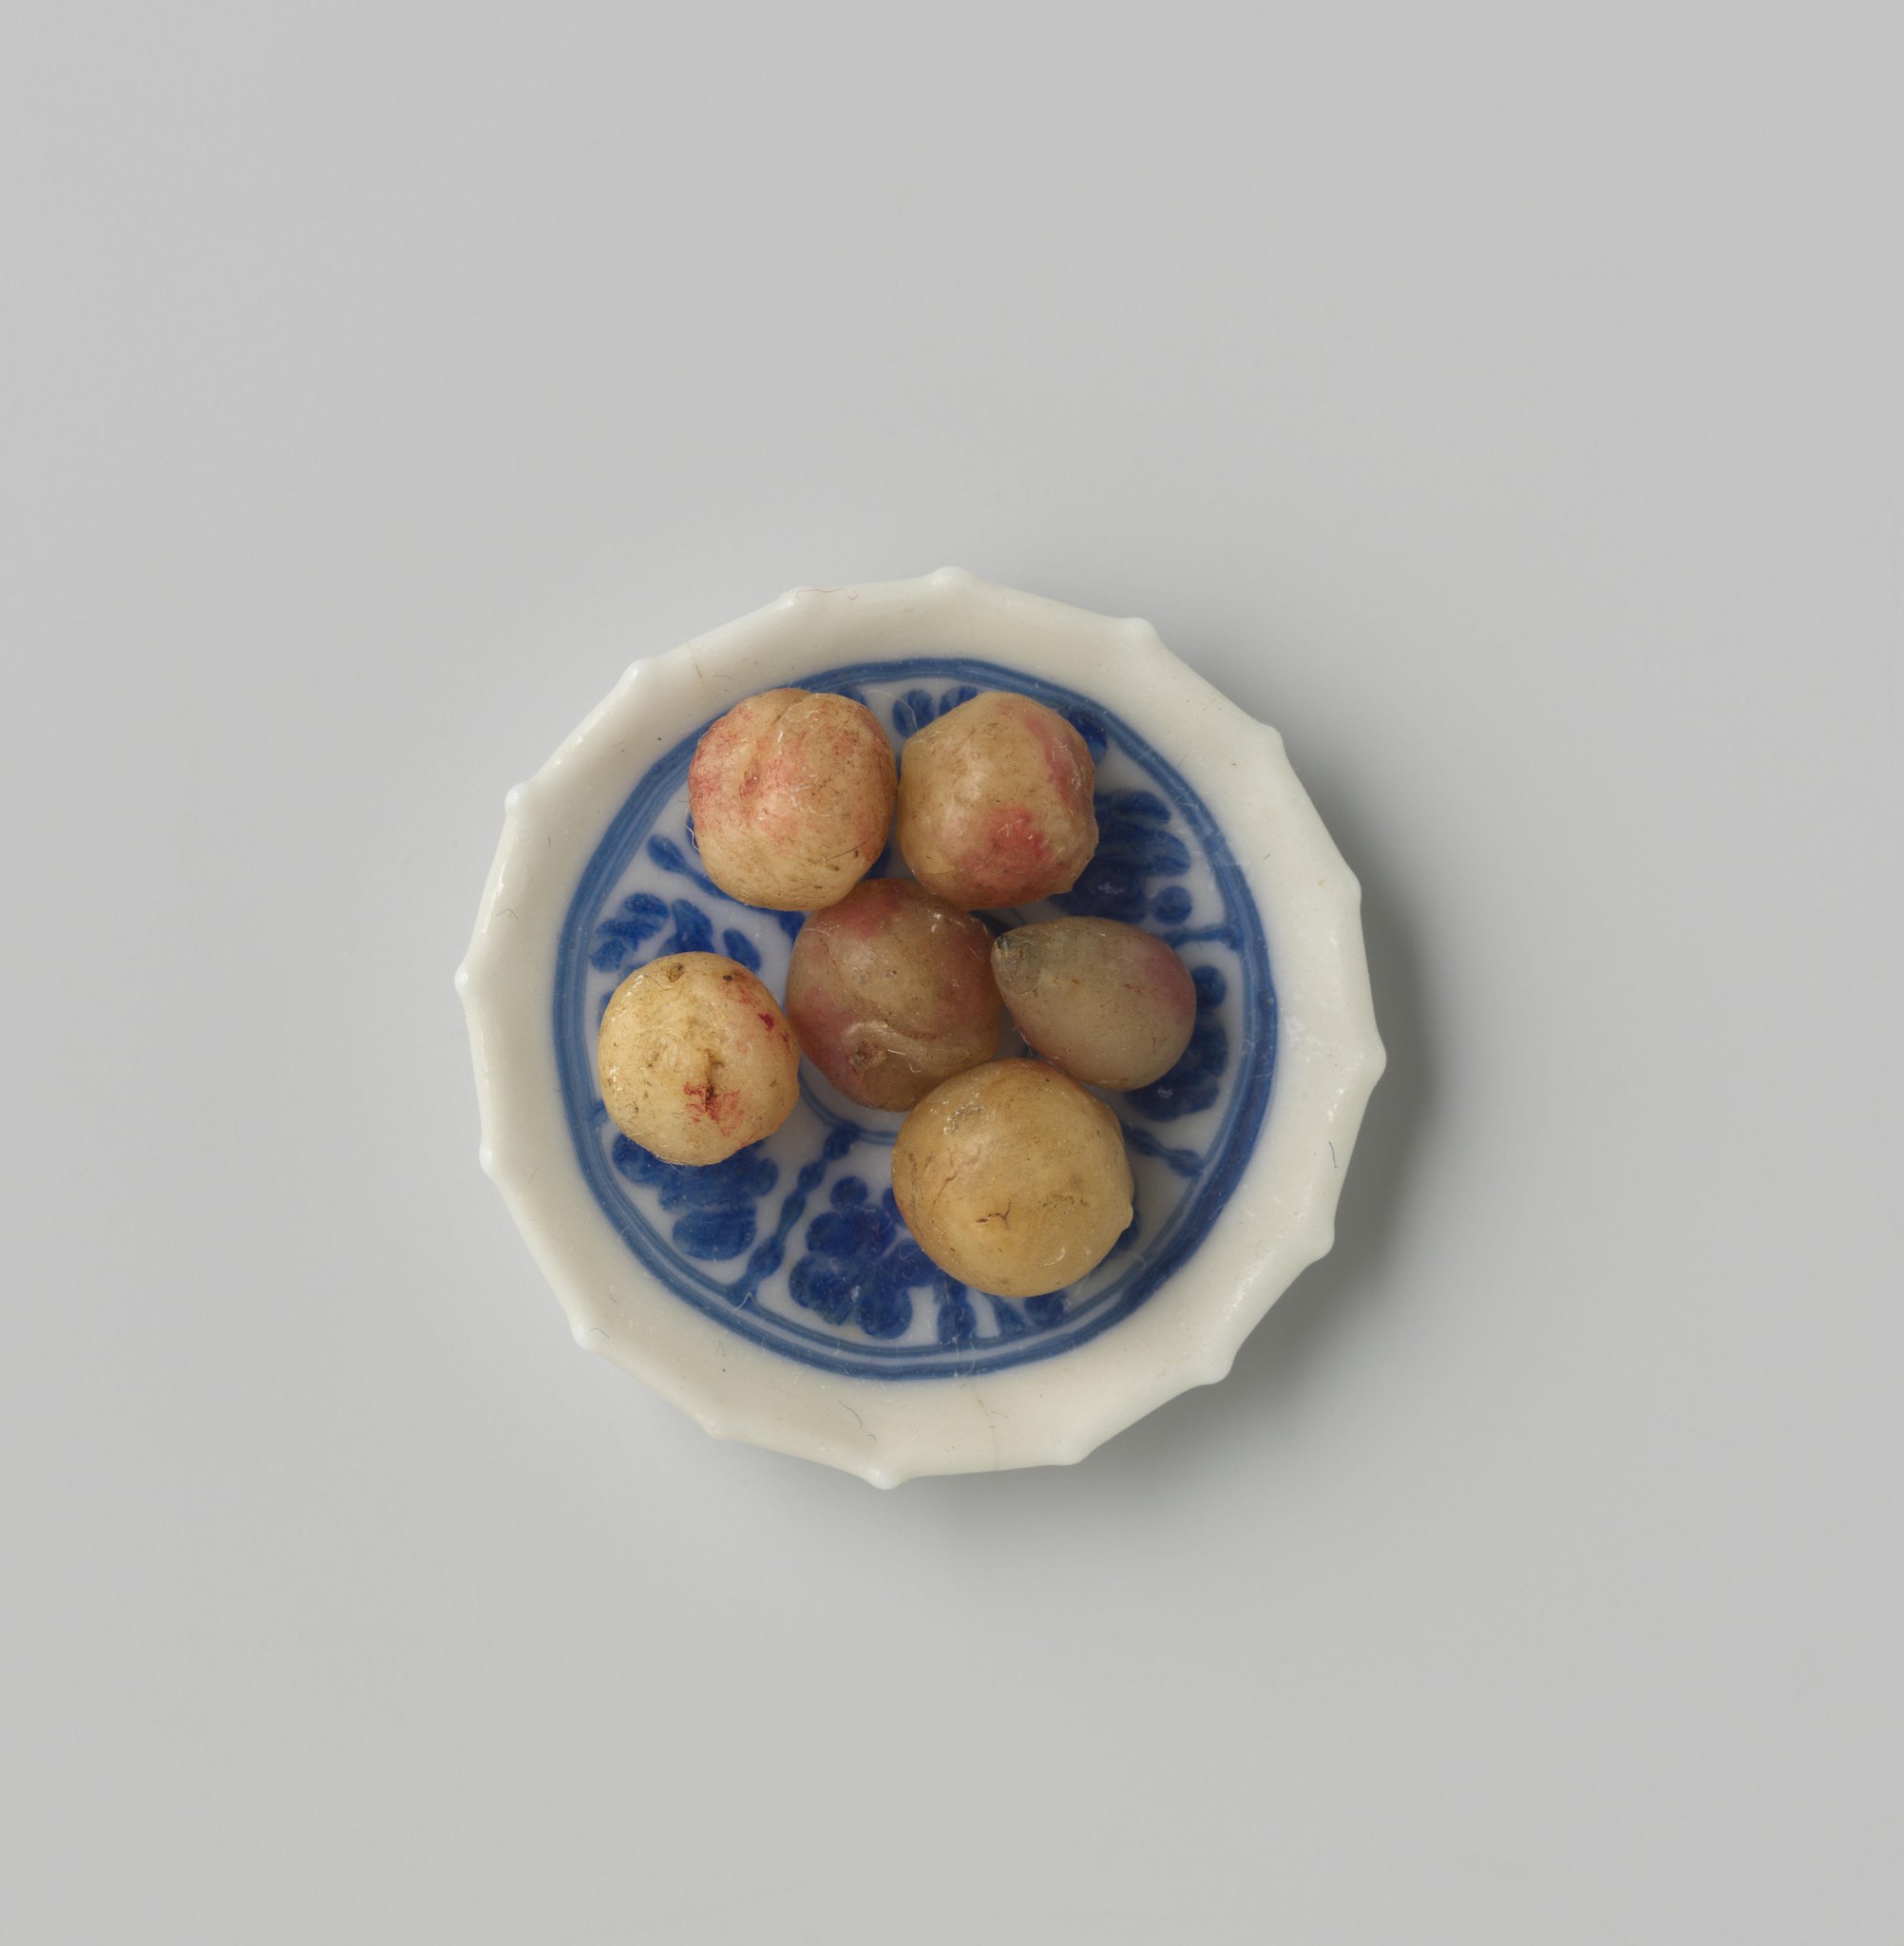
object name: miniature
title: Schotel van melkglas met blauwe emailverf beschildering, imitatie Chinees porselein; bloemmotieven in vakken in Kraakporselein stijl; dubbelwandig met in punten geknepen rand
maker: Anonymous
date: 1675-1710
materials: glass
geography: amsterdam